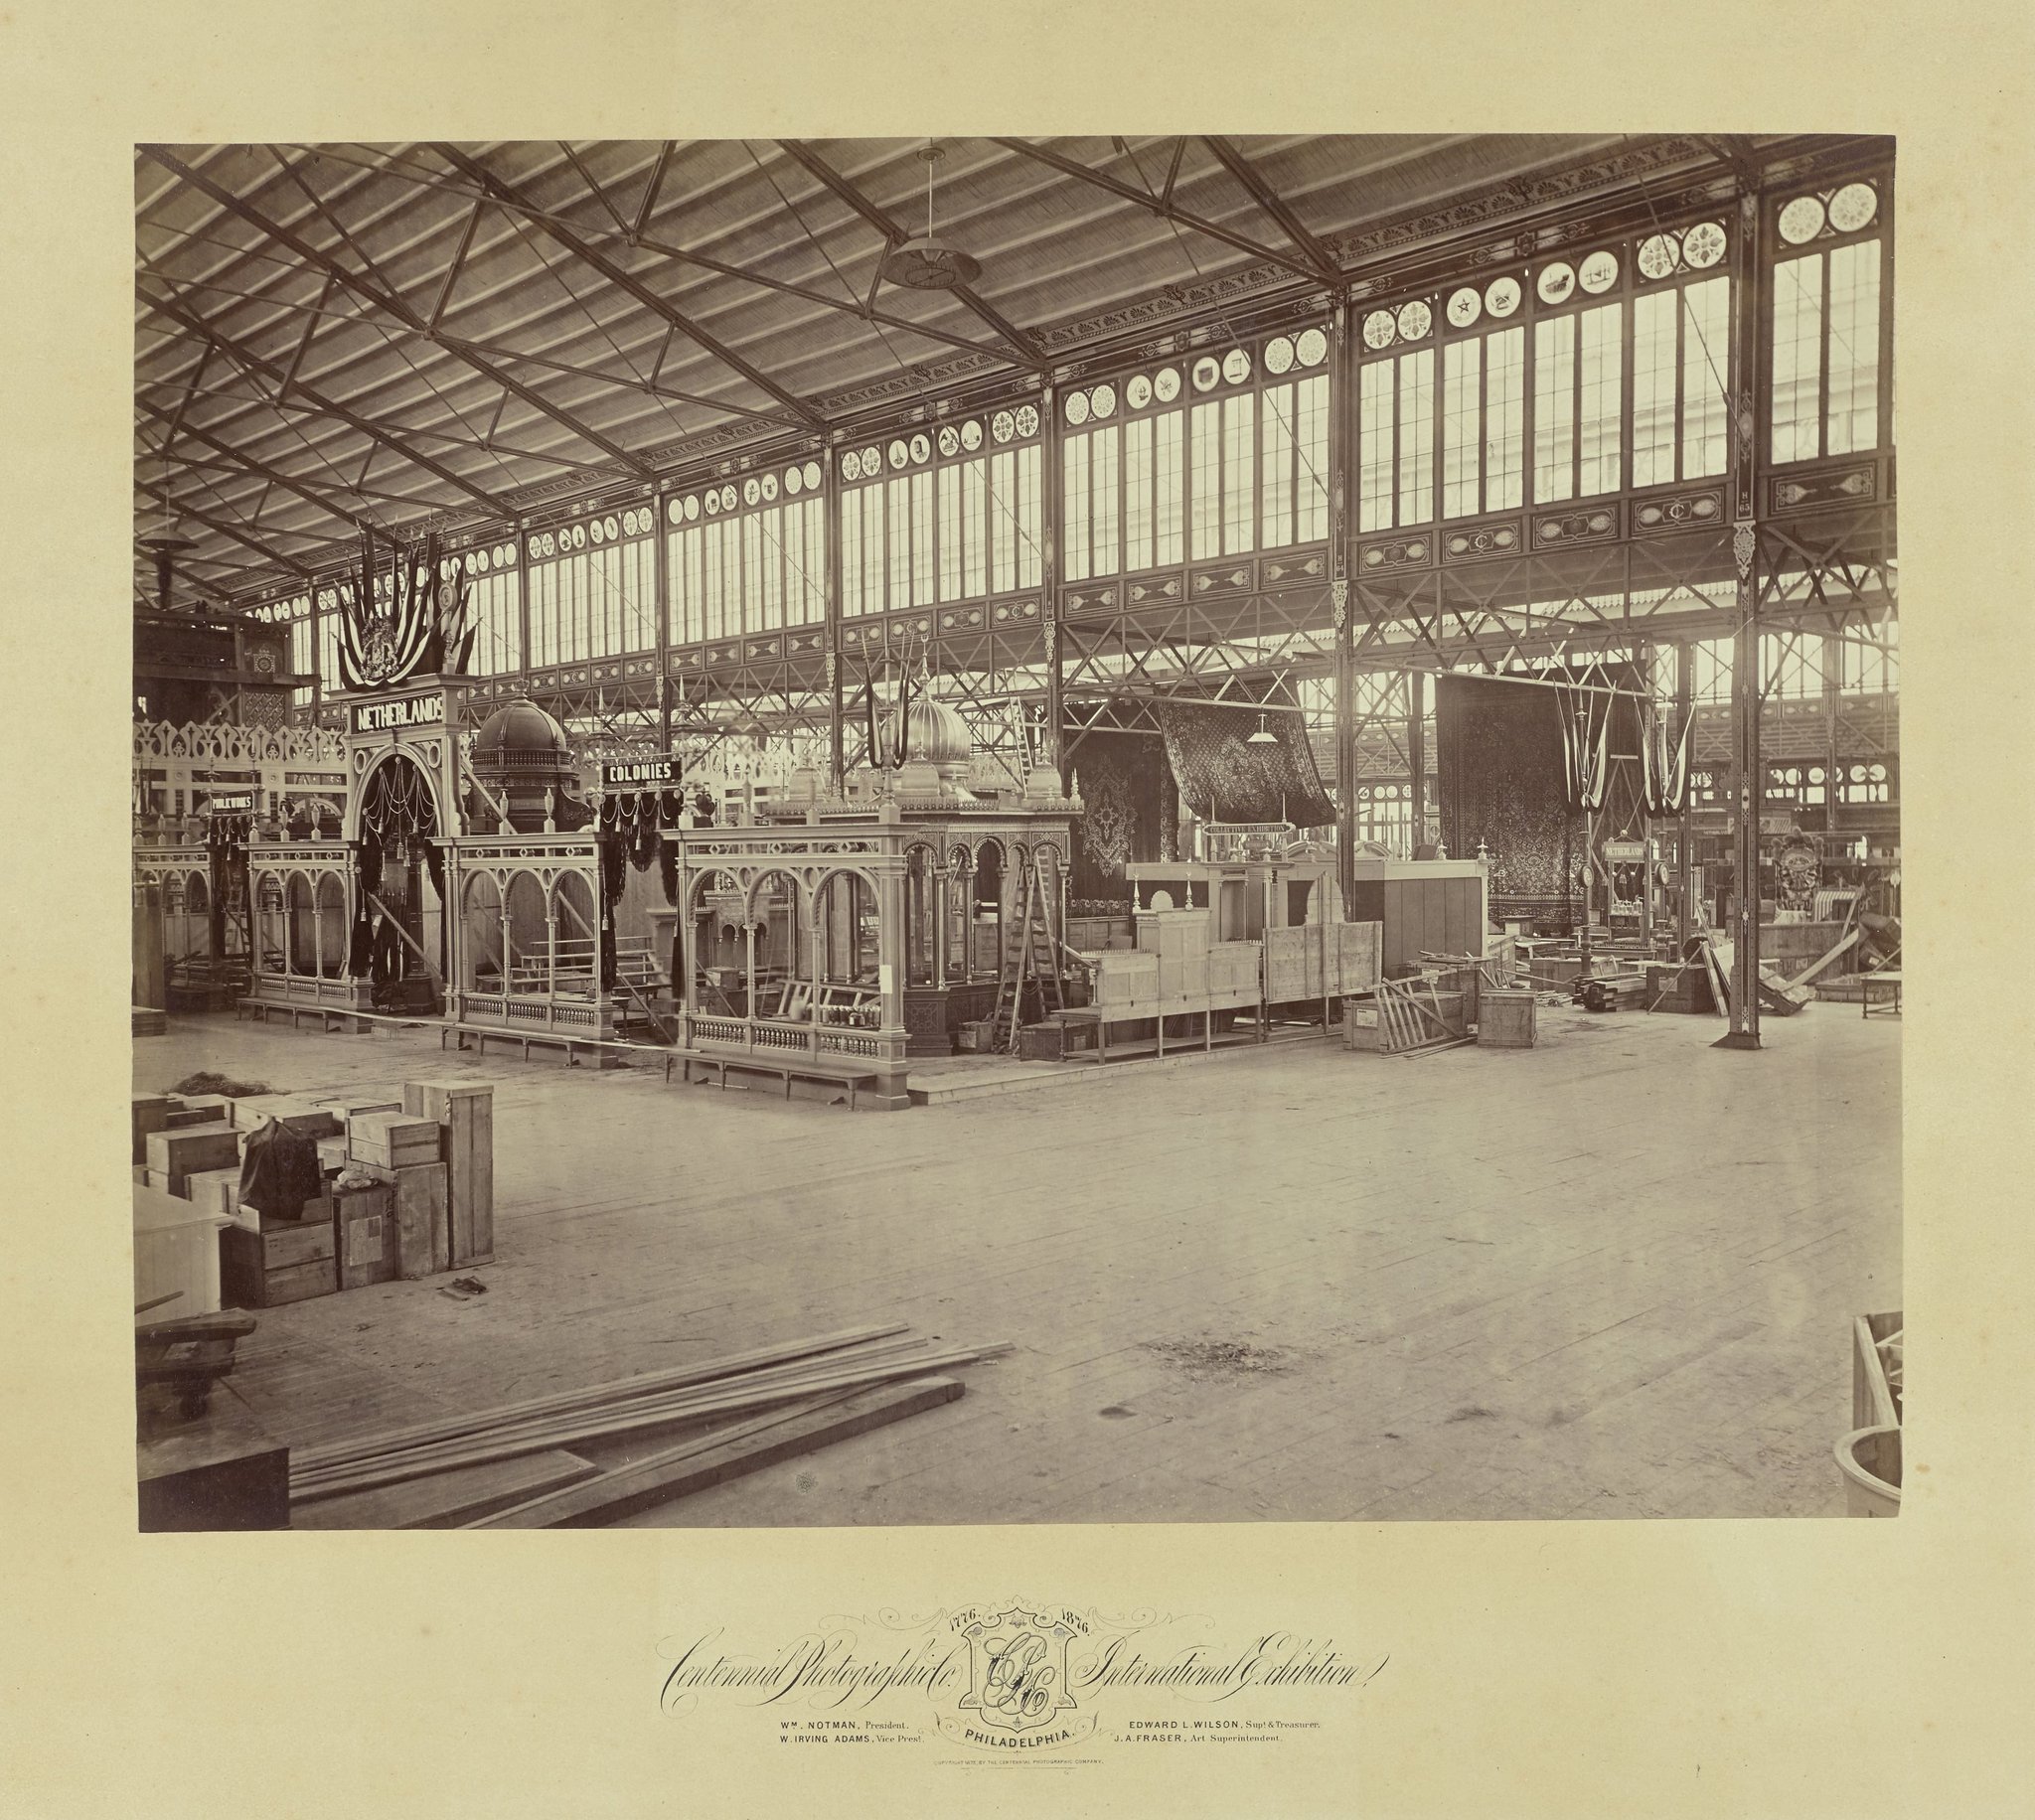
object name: photograph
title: Opbouw van de Nederlandse afdeling in de International Exhibition Philadelphia, 1876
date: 1876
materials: cardboard, paper, photographic support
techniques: albumen print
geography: philadelphia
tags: trade exhibition, industries fair, collection, exhibition, show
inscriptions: collector's mark: Lugt 2166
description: Opbouw van de Nederlandse afdeling in de tentoonstellingszaal van de International Exhibition te Philadelphia in de Verenigde Staten, 1876.